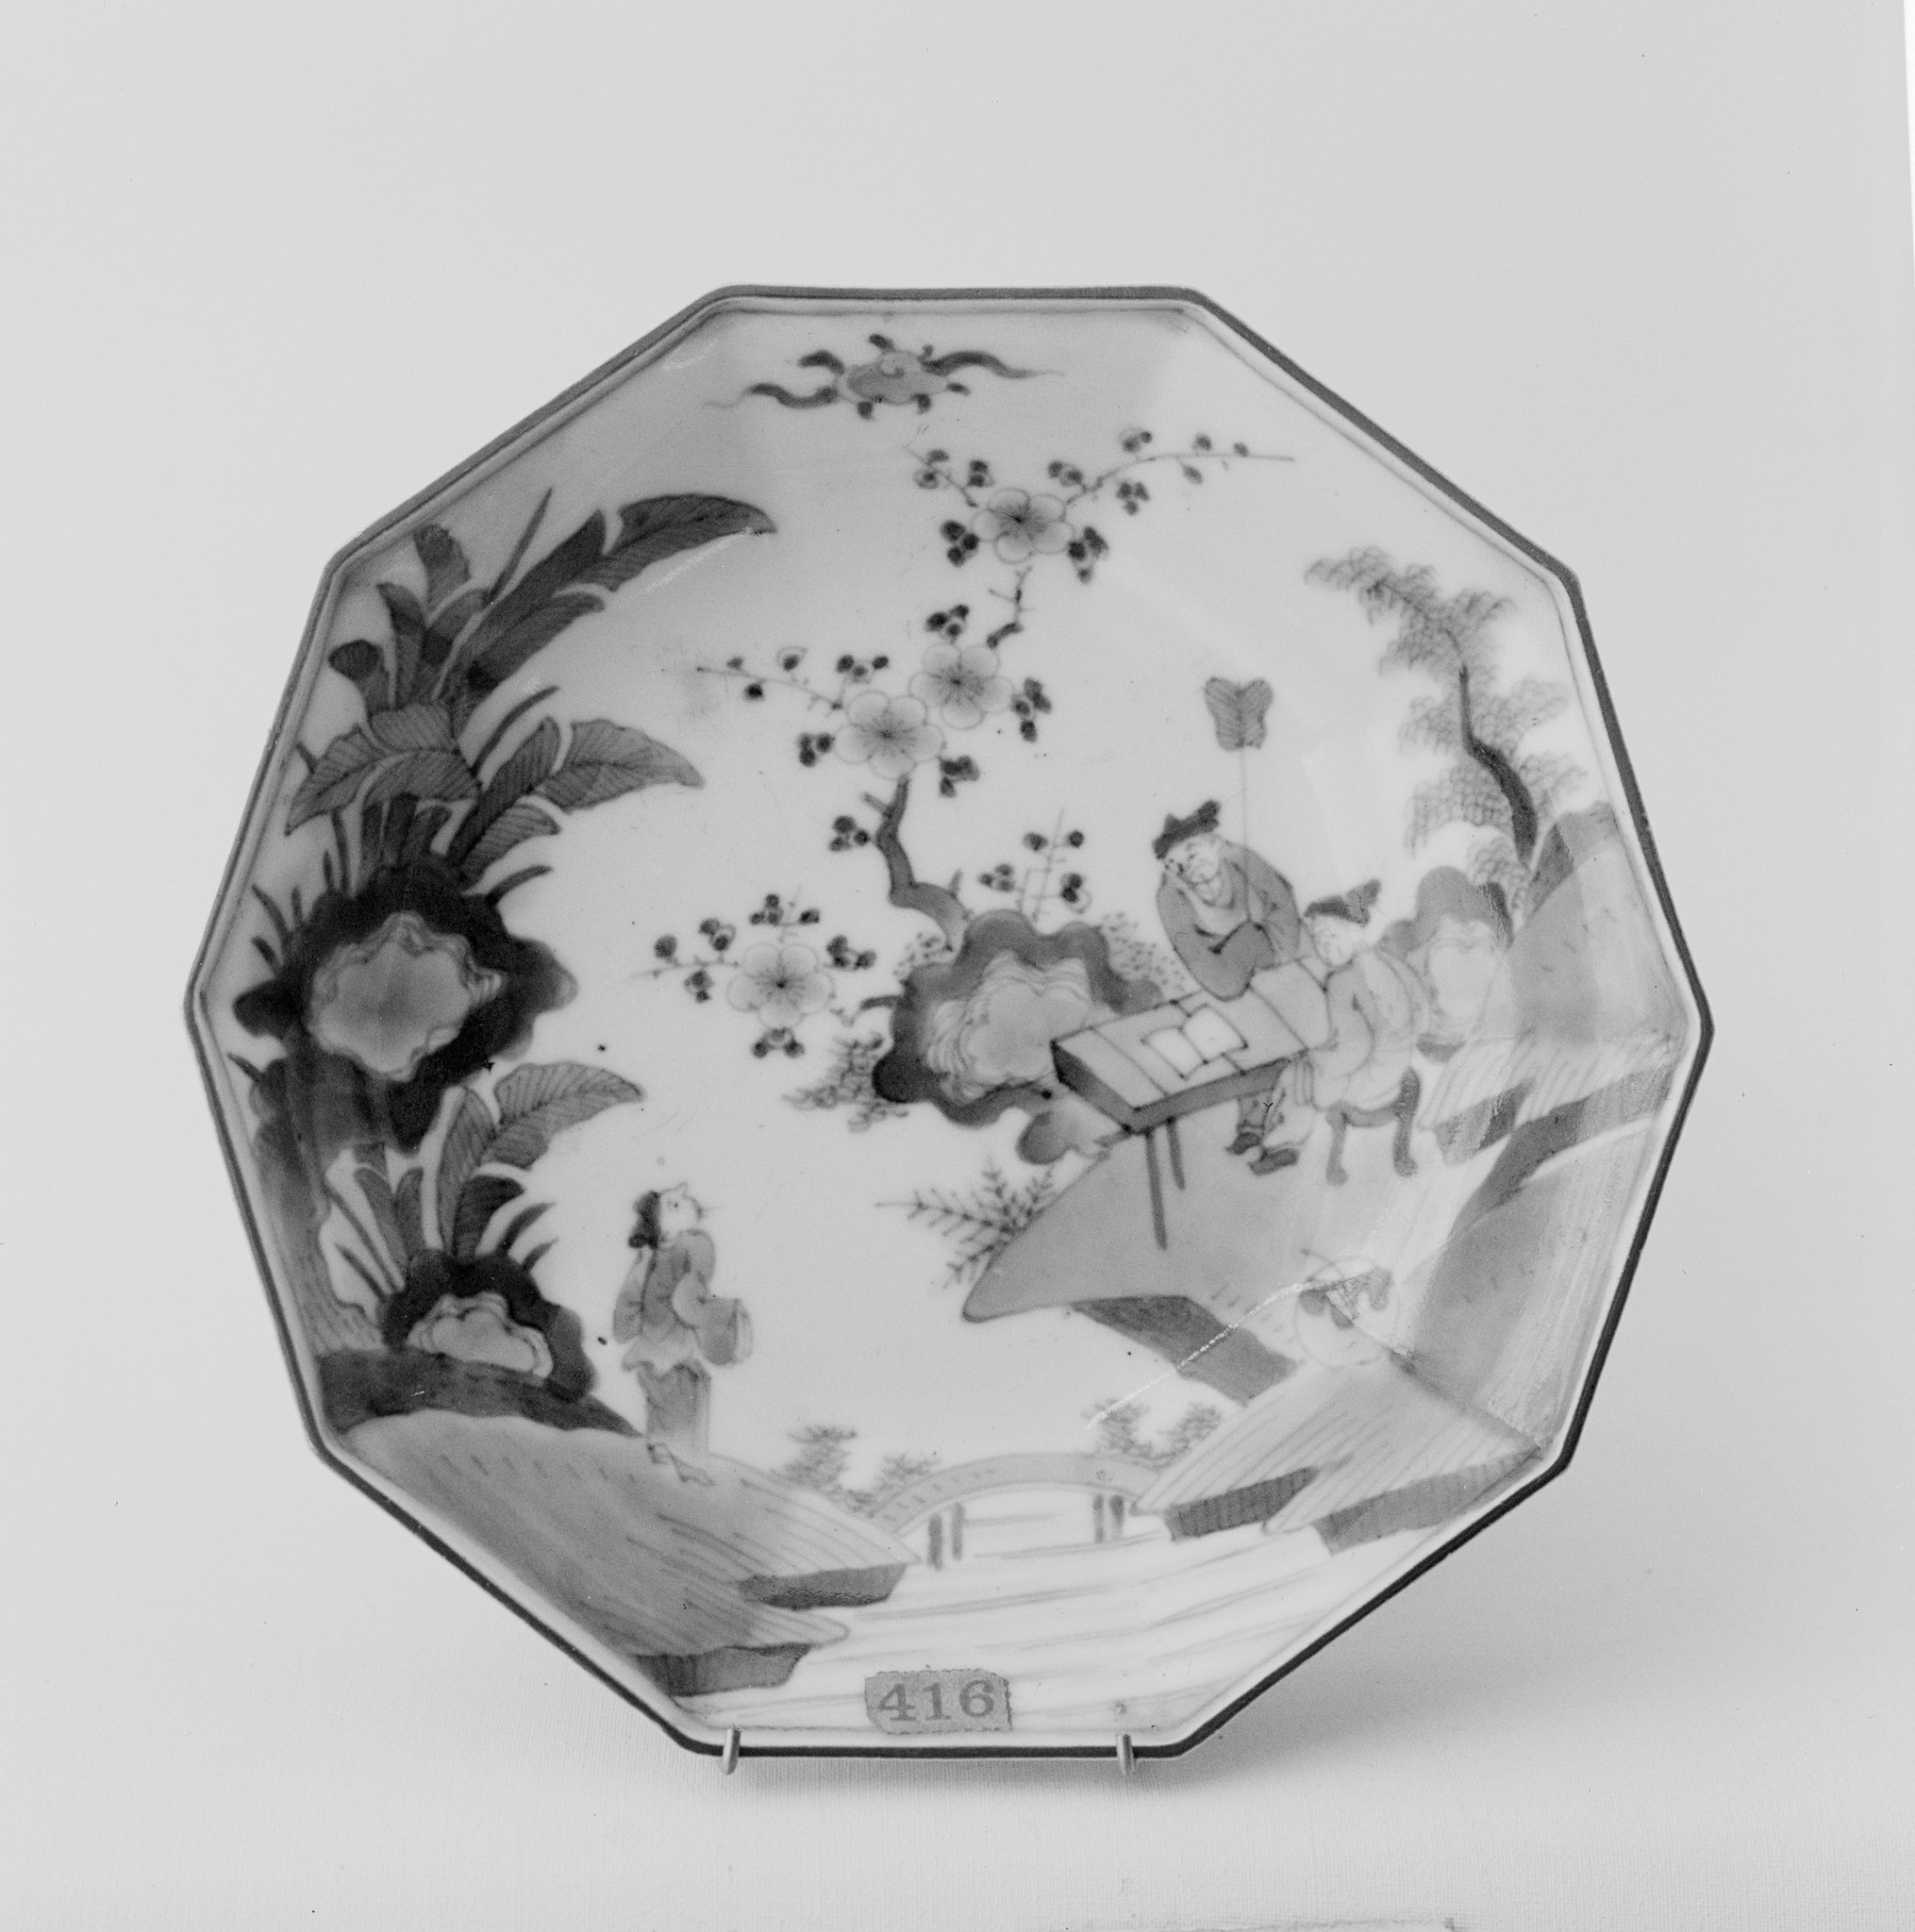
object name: dish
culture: japanese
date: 1701-1800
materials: glaze, porcelain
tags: human figures,flowers,trees